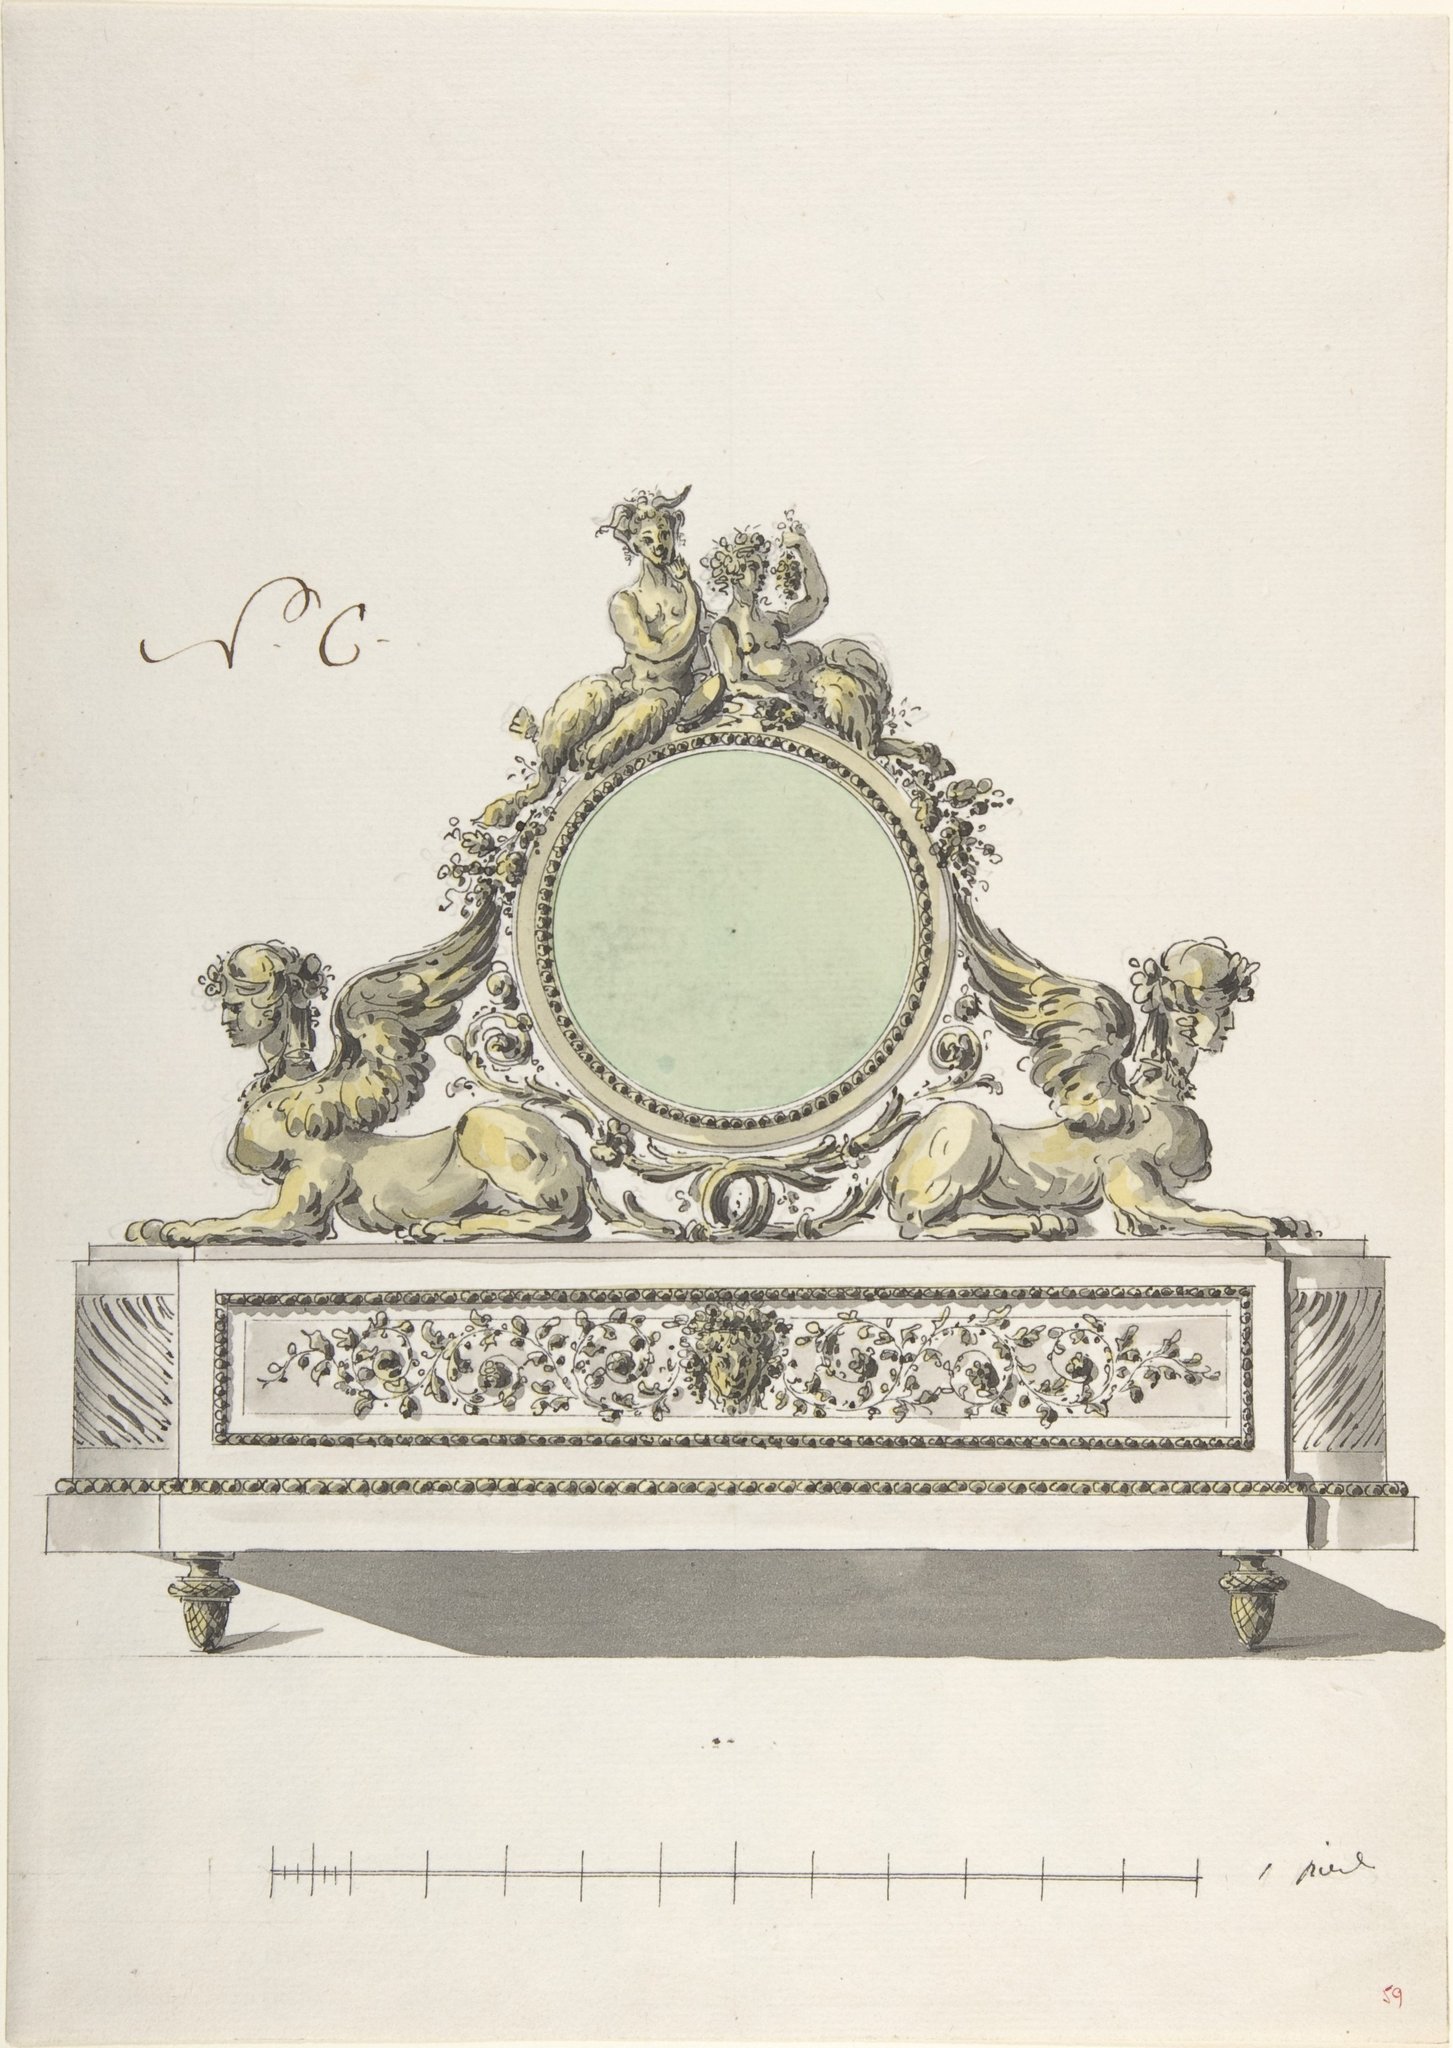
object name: drawing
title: Design for a Clock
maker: anonymous, french, 18th century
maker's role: artist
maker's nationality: french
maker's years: 1700-1800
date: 1767-1800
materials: ink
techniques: brush, pen, wash